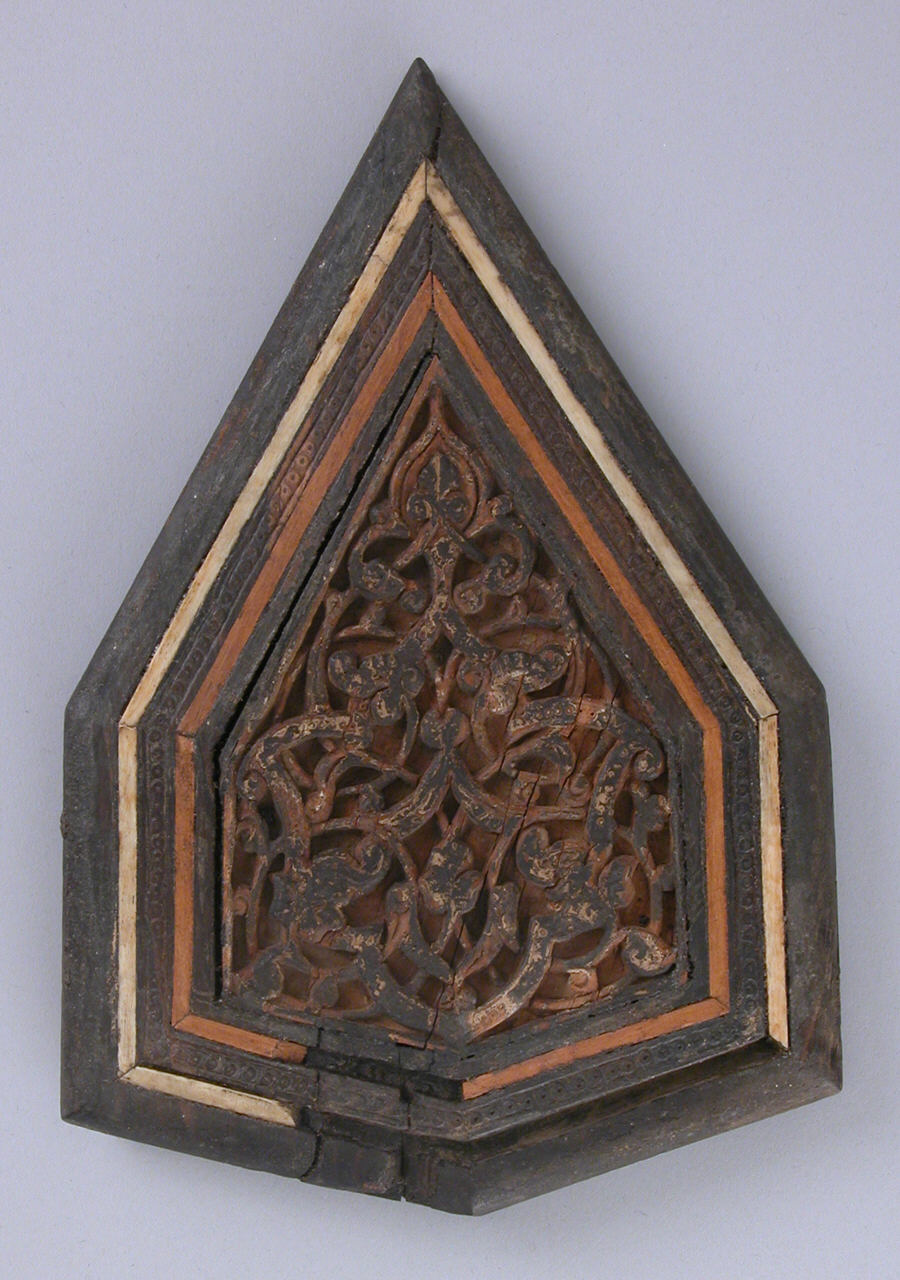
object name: panel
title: Panel from a Minbar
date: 1201-1400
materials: ivory, paint, wood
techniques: carving, inlay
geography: egypt